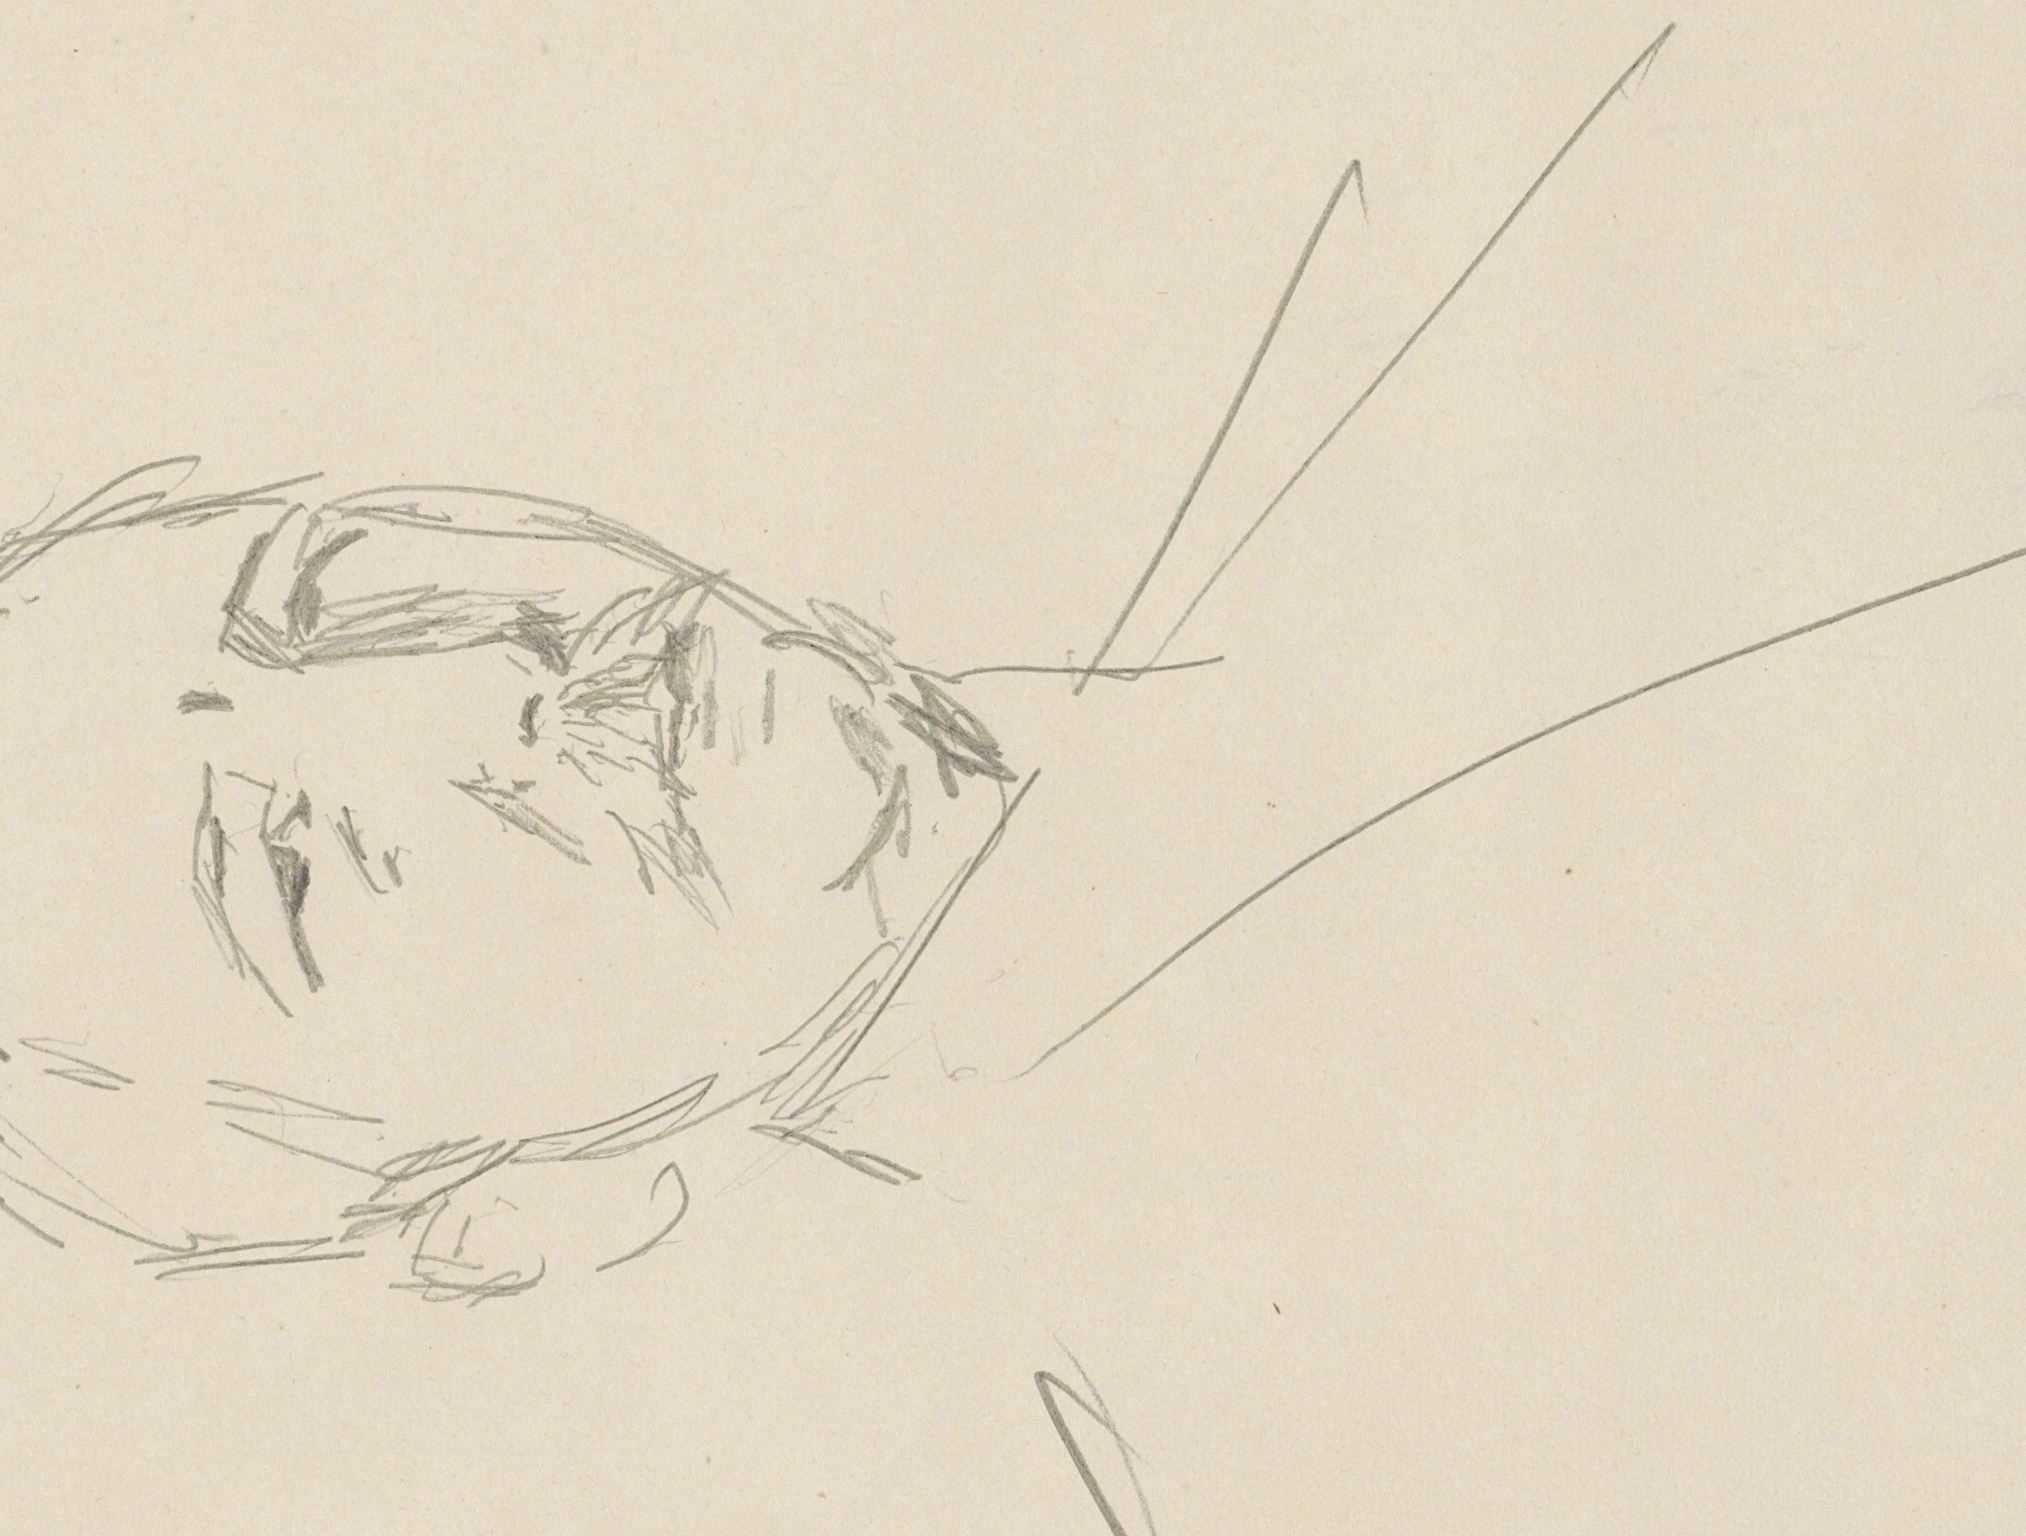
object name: sketchbook leaf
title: Portret van een onbekende man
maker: isaac israels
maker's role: draughtsman, painter, print maker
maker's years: 1865-1934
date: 1875-1934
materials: paper, pencil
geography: the hague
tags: anonymous historical person portrayed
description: Blad 10 recto uit schetsboek XXIII met 20 bladen.